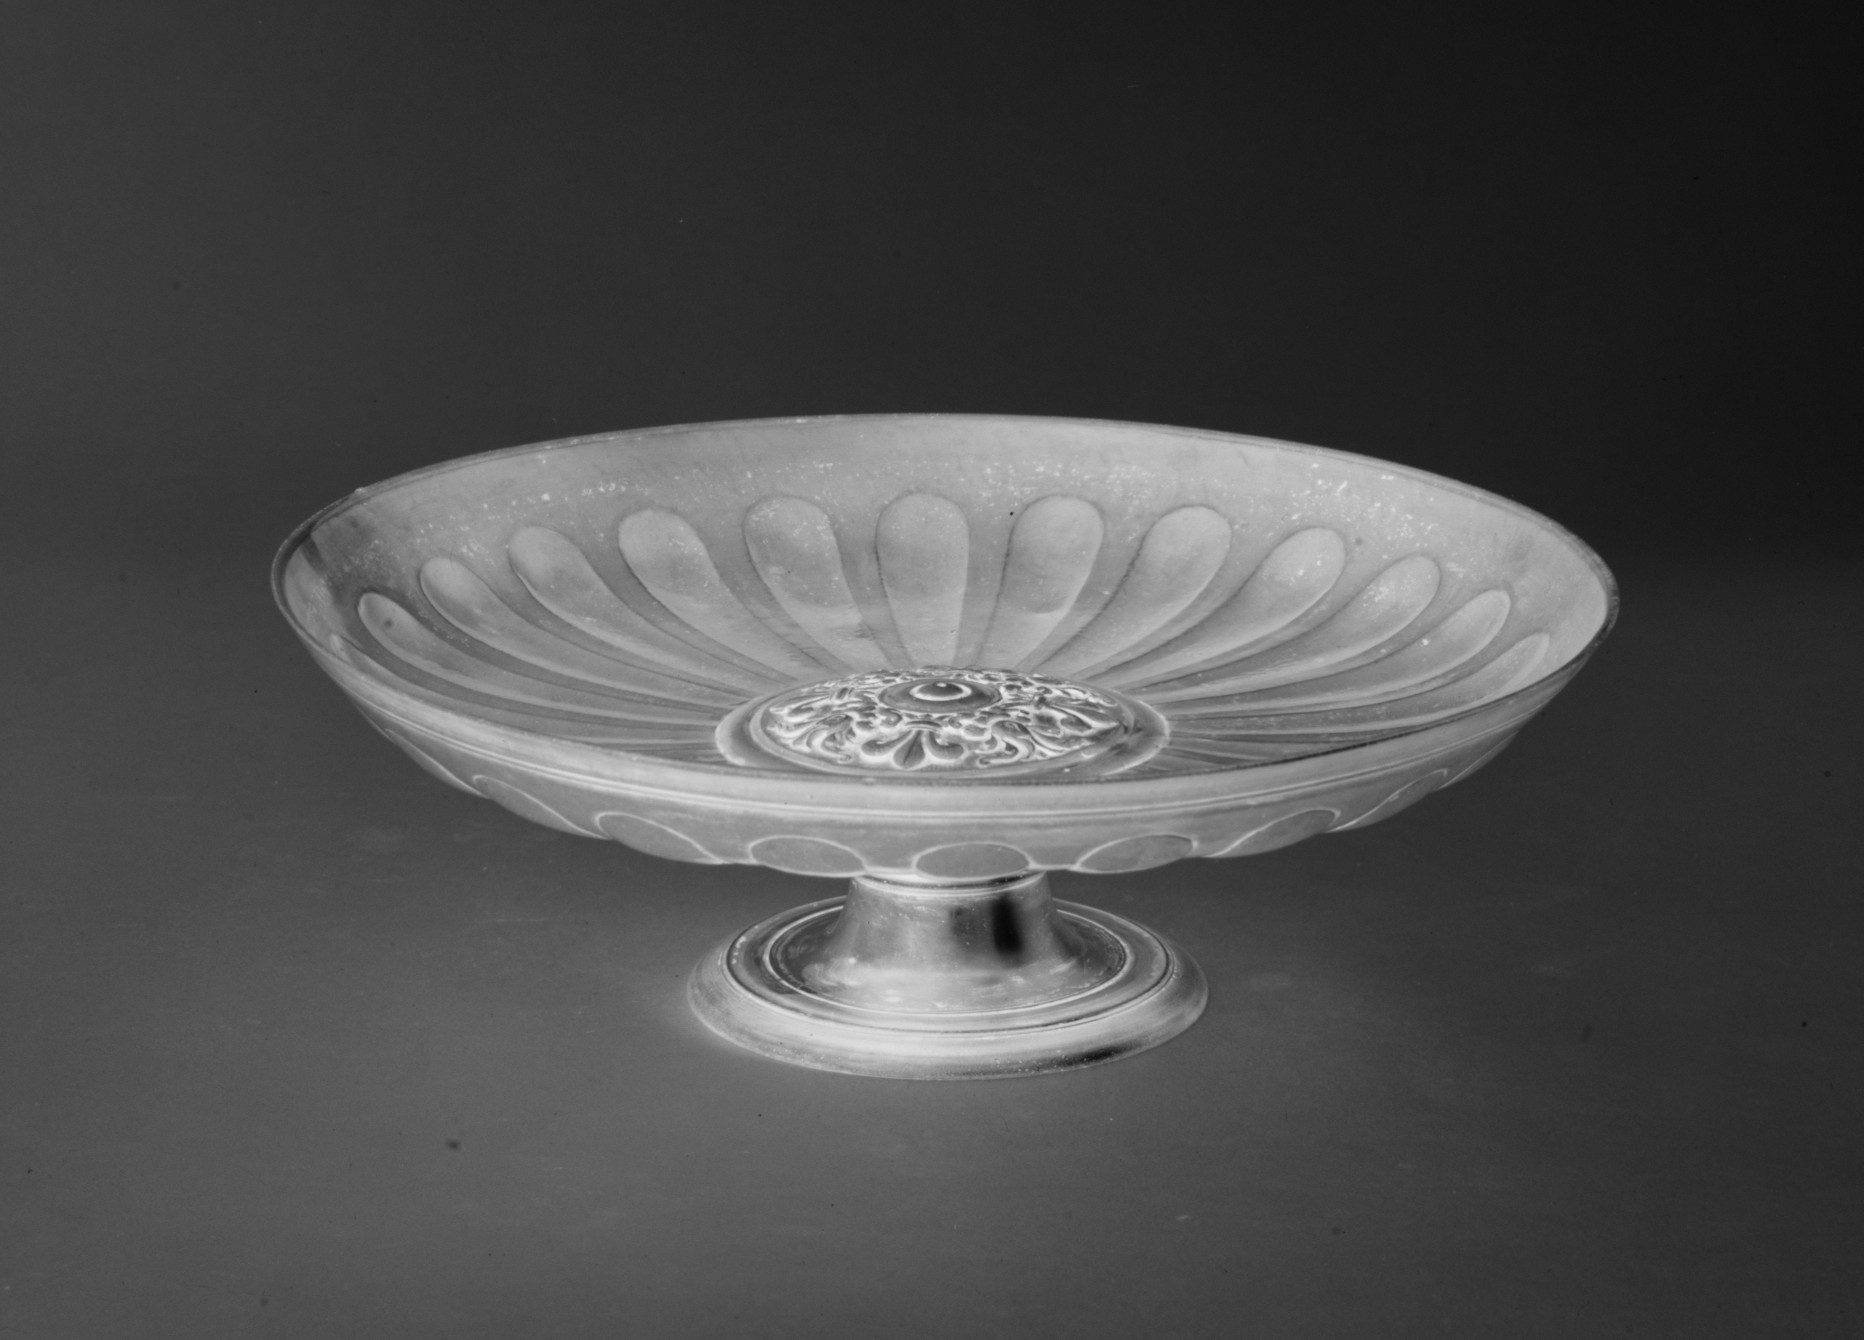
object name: salver on pedestal foot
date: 1551-1600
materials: gilt, silver